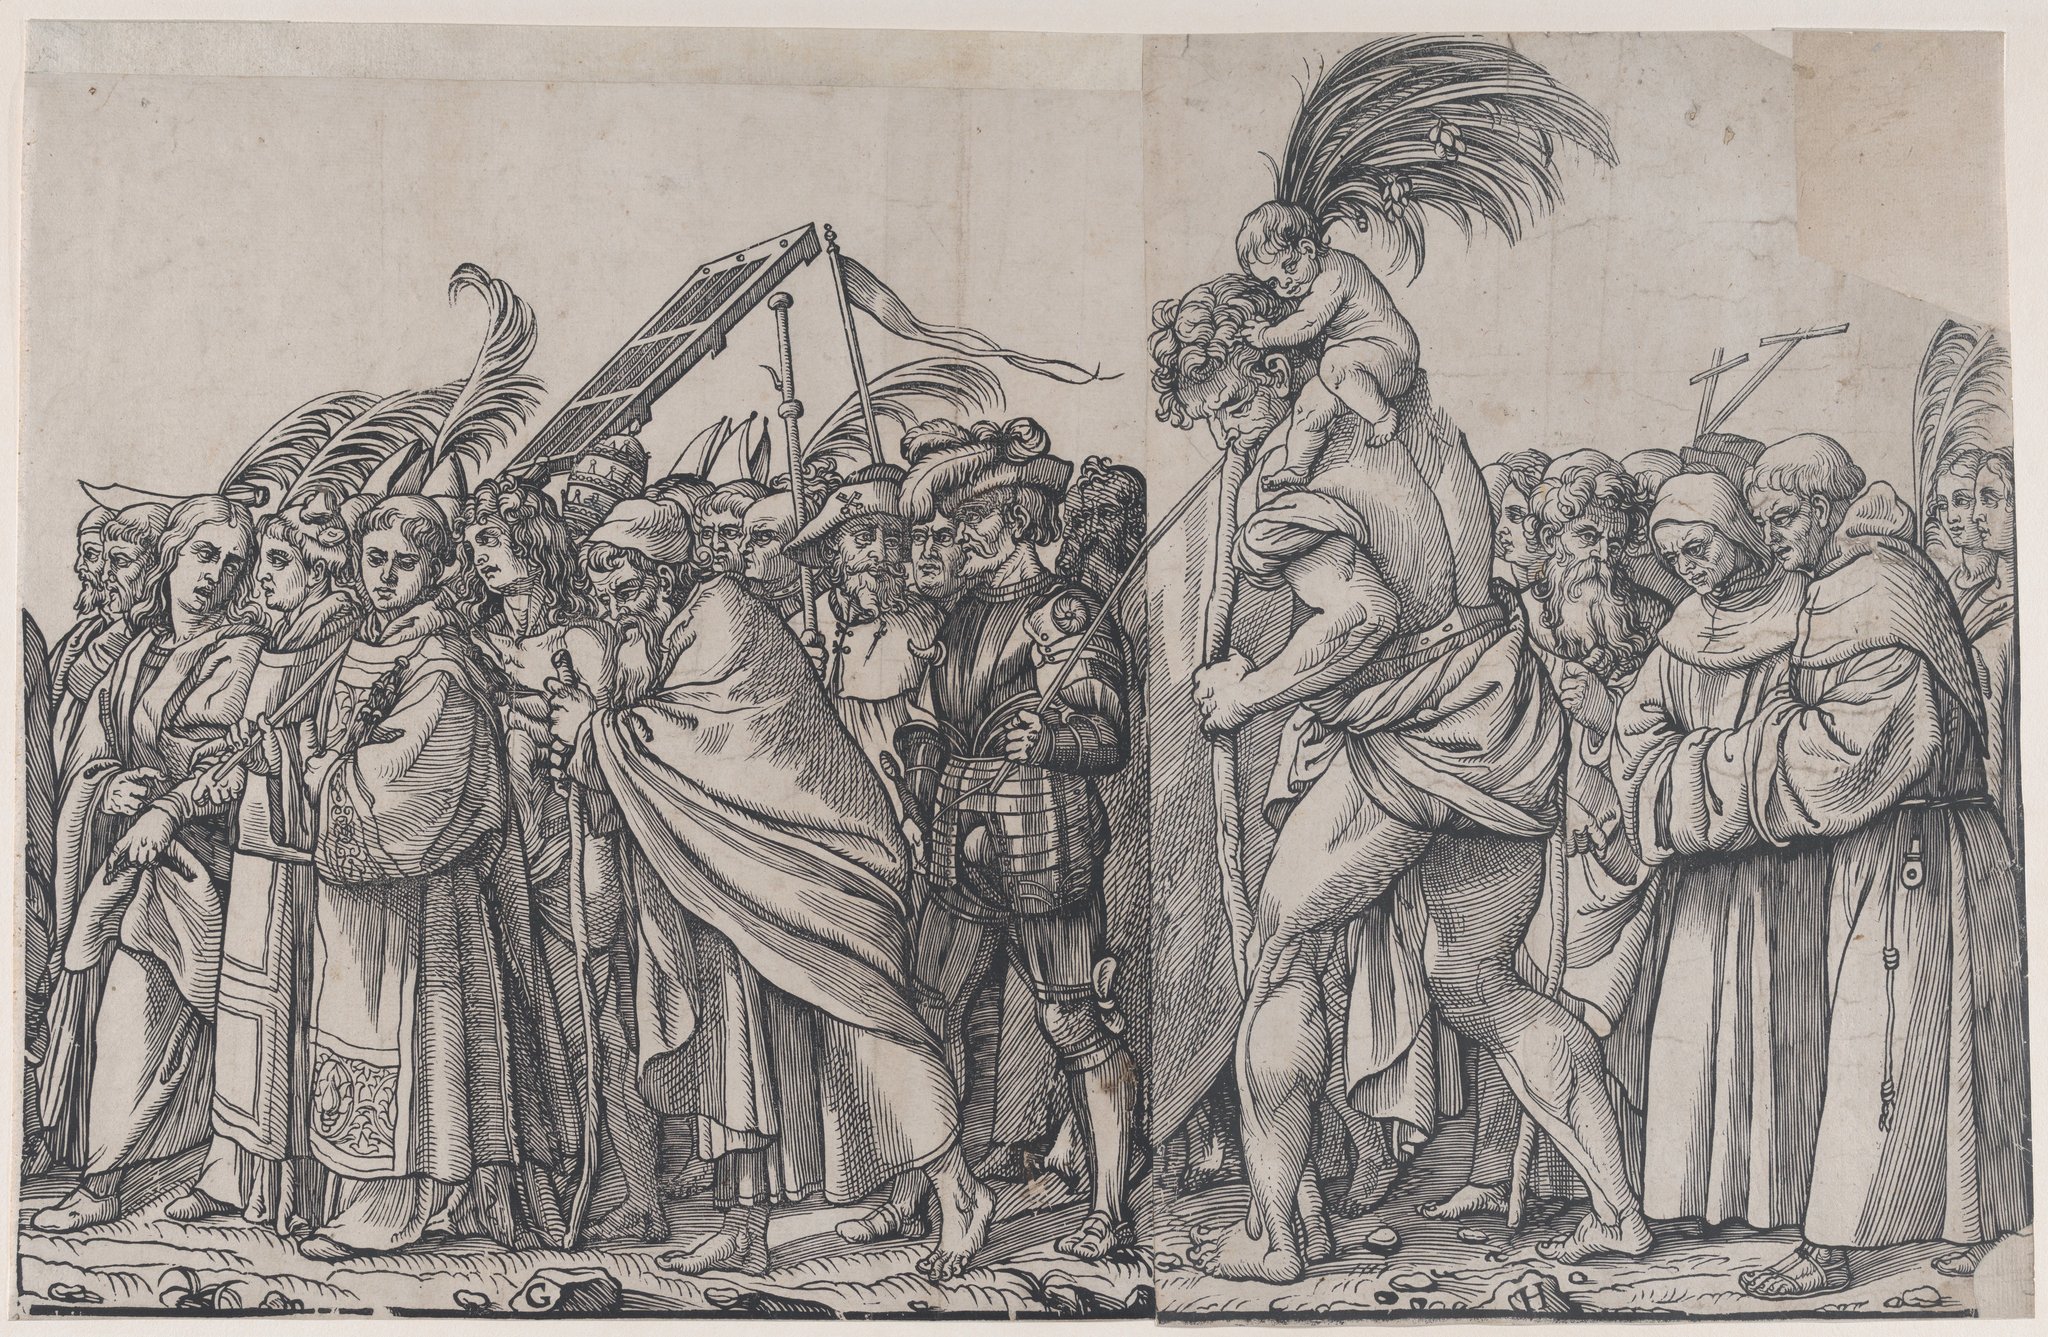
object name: print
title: Section H: Saint Christopher carrying the Christ Child, from "The Triumph of Christ"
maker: andrea andreani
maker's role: artist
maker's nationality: italian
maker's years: 1558-1629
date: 1836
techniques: lithograph, woodcut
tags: men,christ,saint christopher